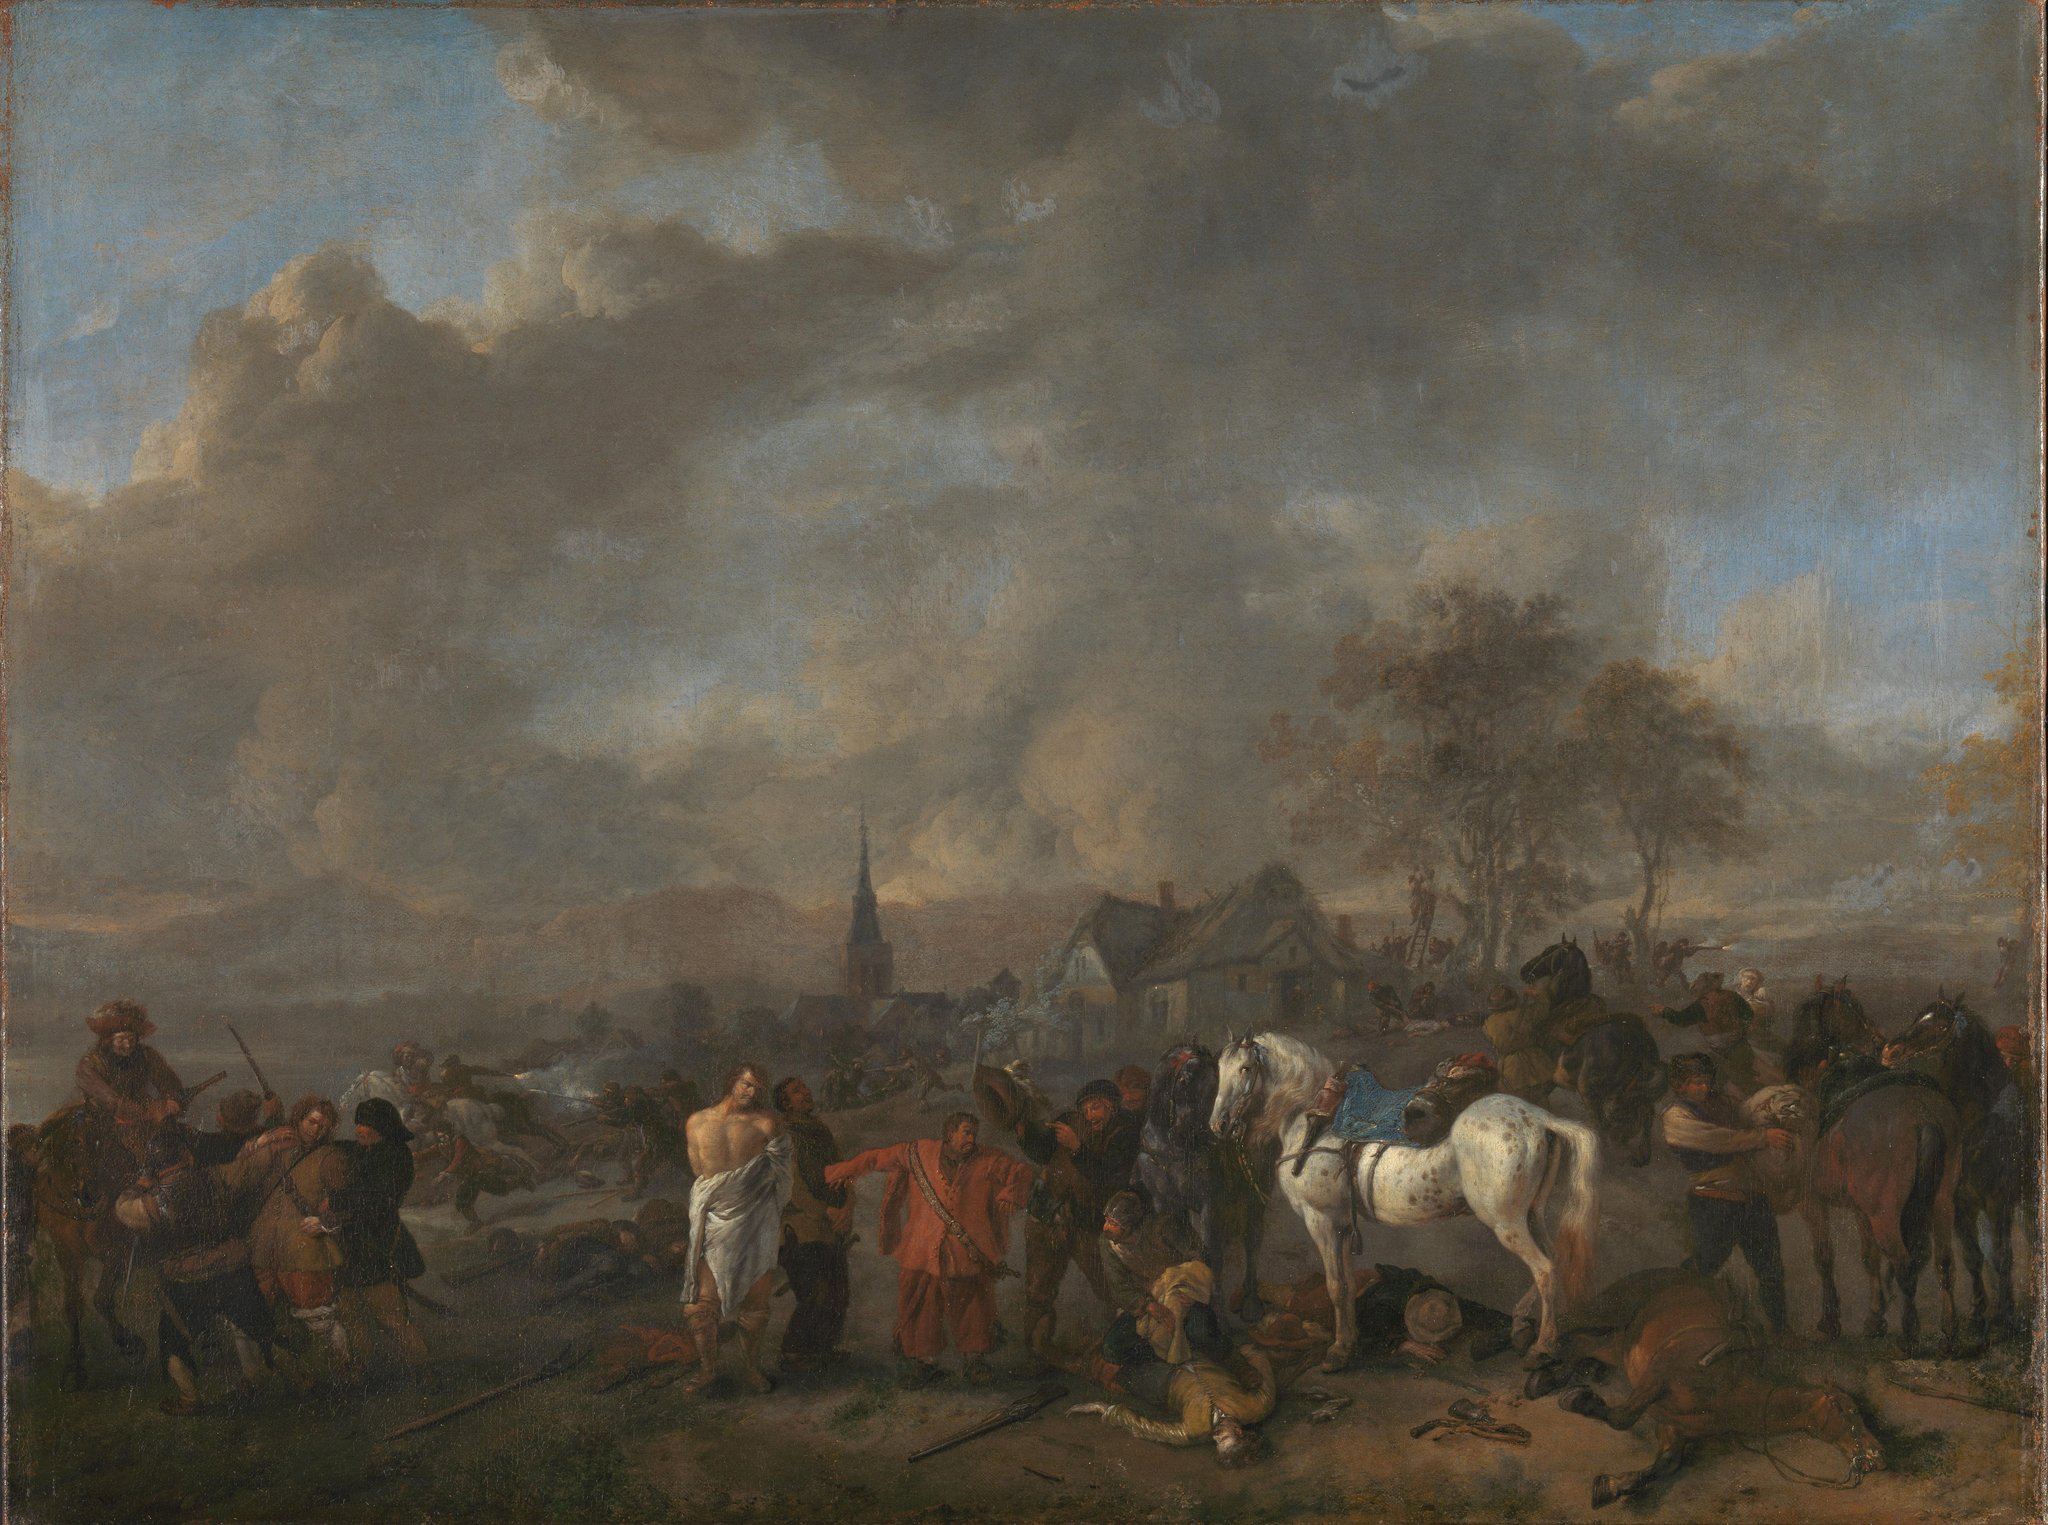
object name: painting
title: The Victory of the Peasants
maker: philips wouwerman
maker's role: draughtsman, painter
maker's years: 1619-1668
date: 1665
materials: canvas, oil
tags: fight between farmers and soldiers, soldiers and civilians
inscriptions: signature, with monogram, bottom left (letters of first name ligated): ‘PHils . W’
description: De overwinning der boeren. Gevechten bij een dorp waarbij de dorpsbewoners de krijgslieden die hun overvielen weten te overmeesteren. Op de voorgrond worden de soldaten uitgekleed en hun bezittingen doorzocht. Op de achtergrond worden gevangengenomen krijgslieden aan een boom opgehangen.